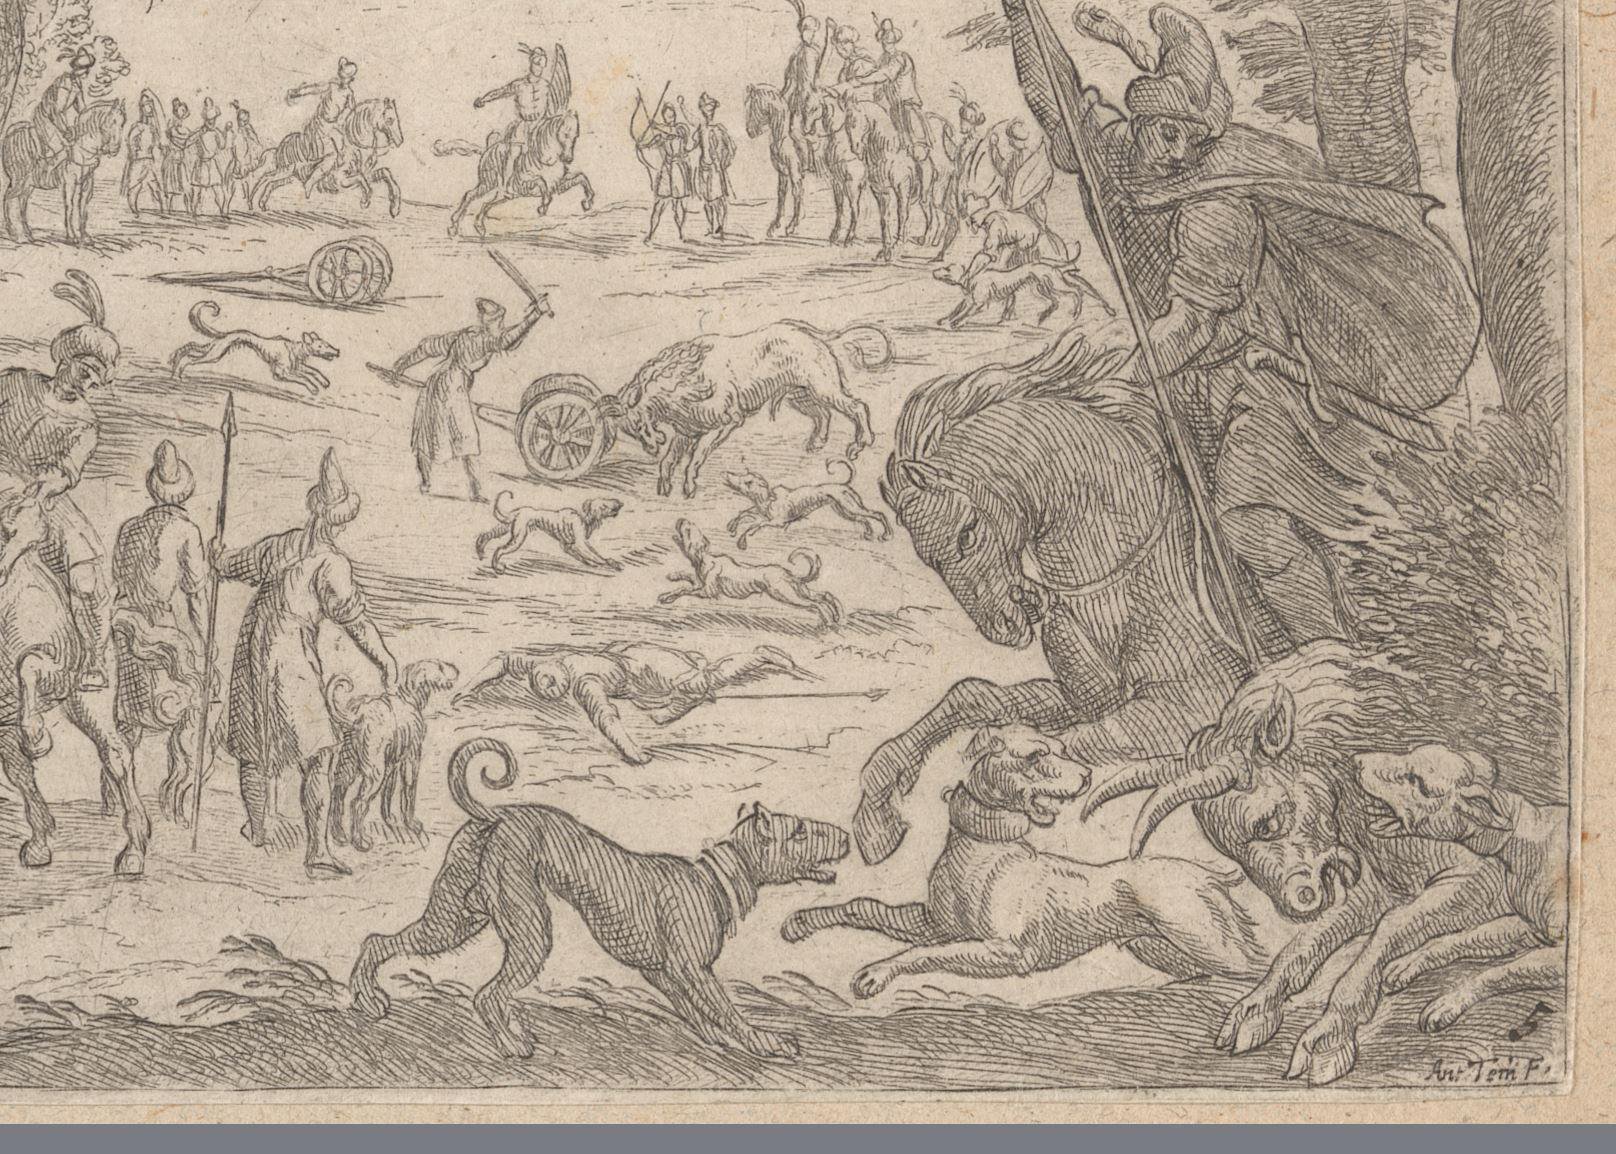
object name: print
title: Jacht op wilde stieren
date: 1598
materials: paper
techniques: etching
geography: italy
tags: bull, hunter, hunters hunting (n.b.: in 1988-1990 this notation denoted the concept of 43c11421 'hunters resting during the hunt'), hunt ~ mammals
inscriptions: collector's mark: ‘Hinloopen’, number: ‘5’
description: Landschap met jagers die jagen op wilde stieren. Op de voorgrond rechts een jager te paard die een stier steekt met zijn speer.